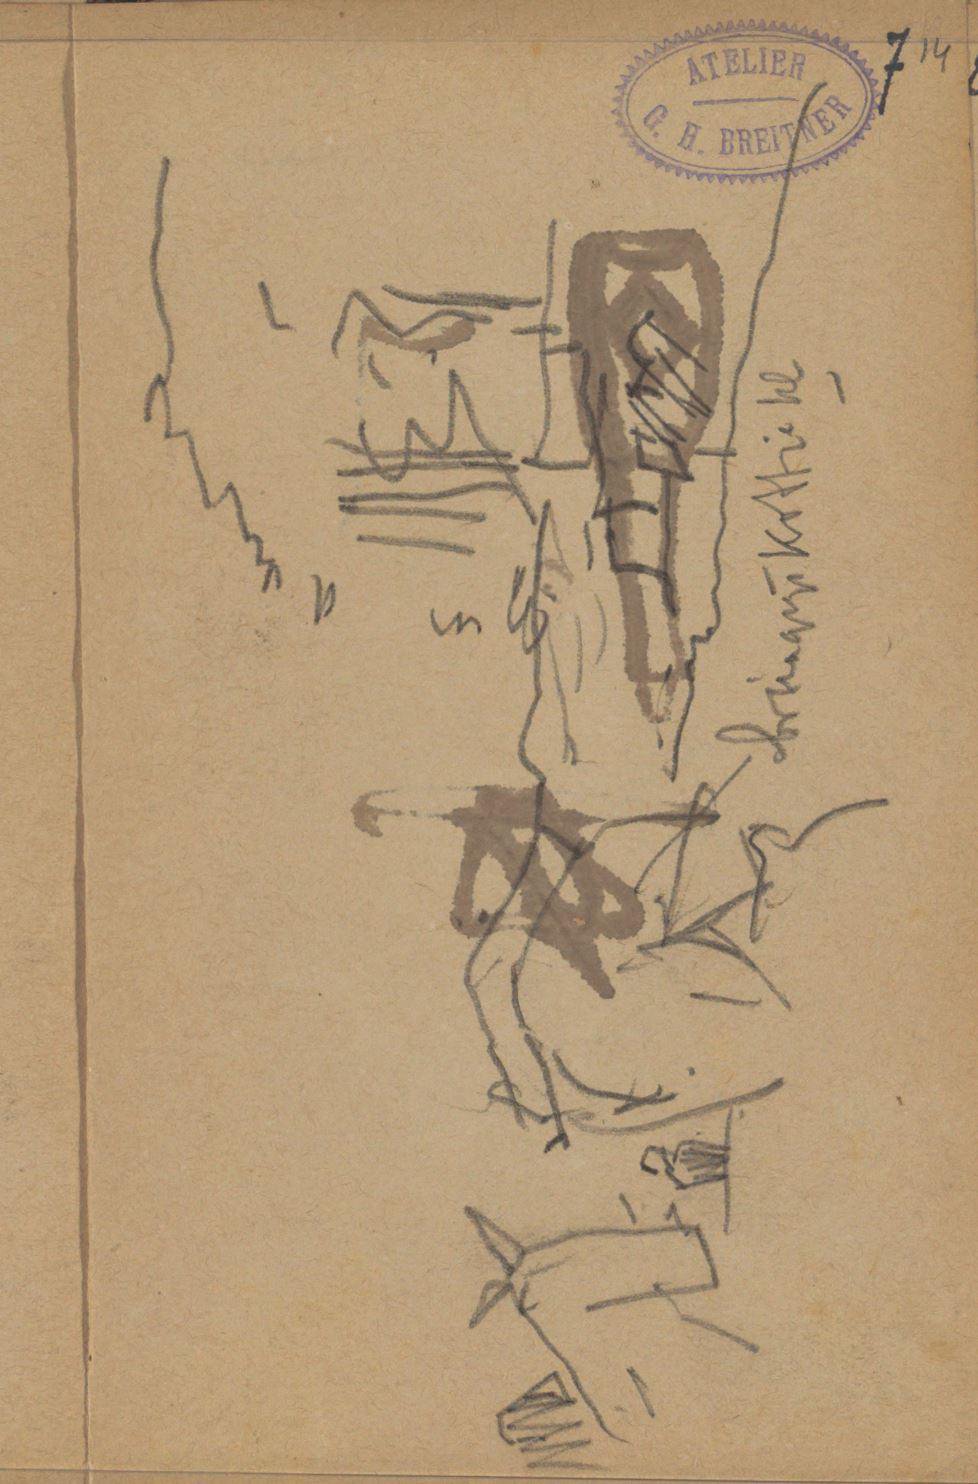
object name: sketchbook leaf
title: Paarden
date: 1887-1891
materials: paper, pencil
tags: horse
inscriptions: kleurnotitie, handgeschreven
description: Pagina 14 uit een schetsboek met 83 bladen.